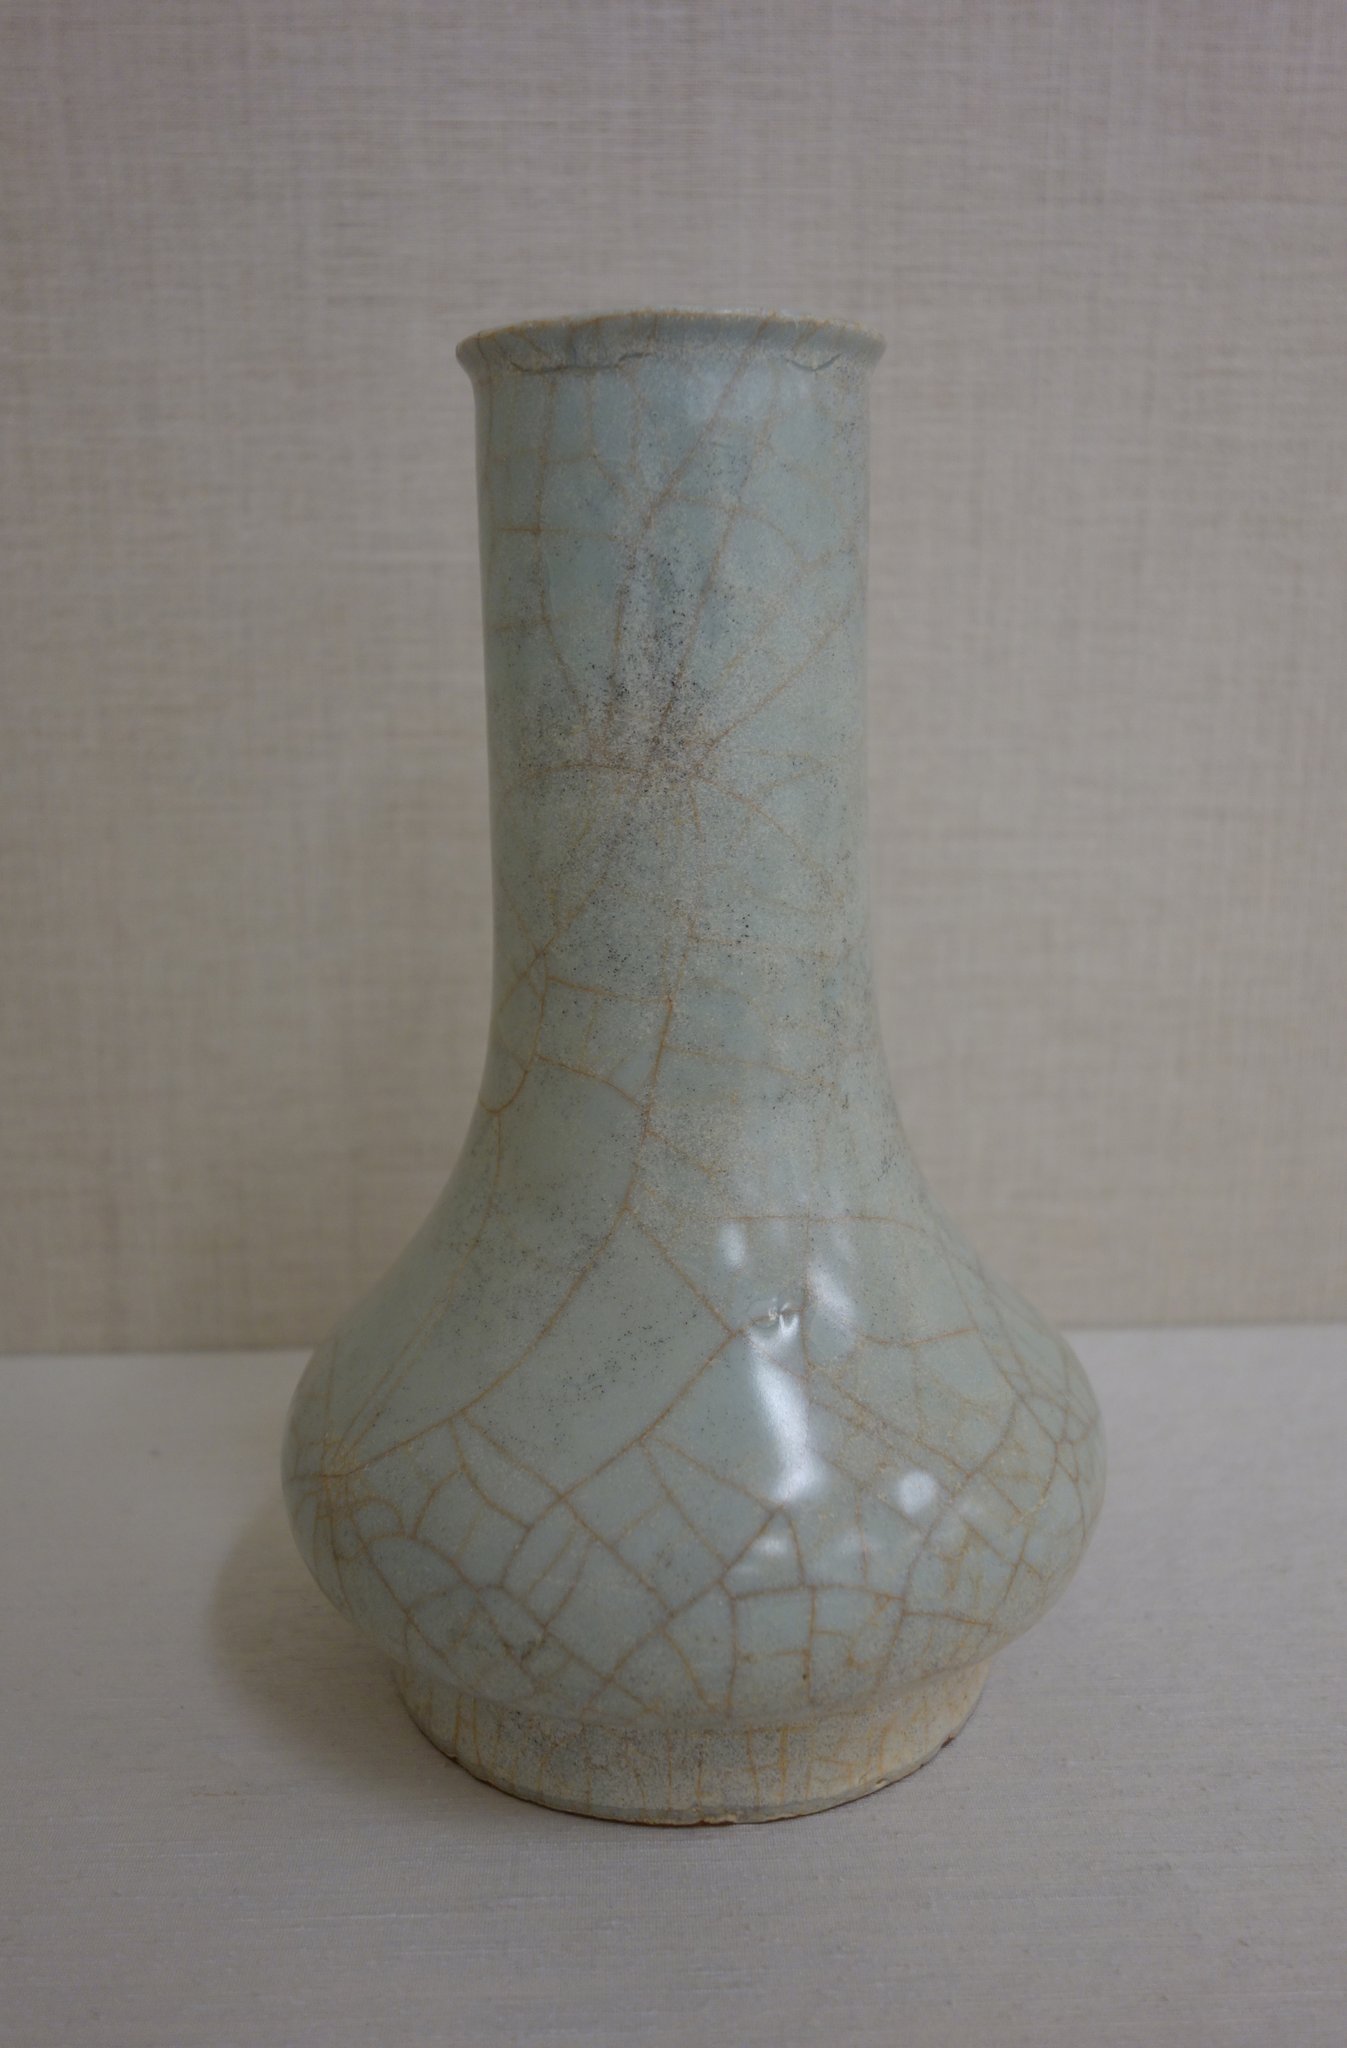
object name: vase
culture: chinese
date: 1101-1300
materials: glaze, stoneware